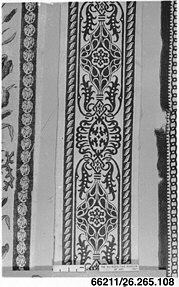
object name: border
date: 1801-1833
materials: cotton